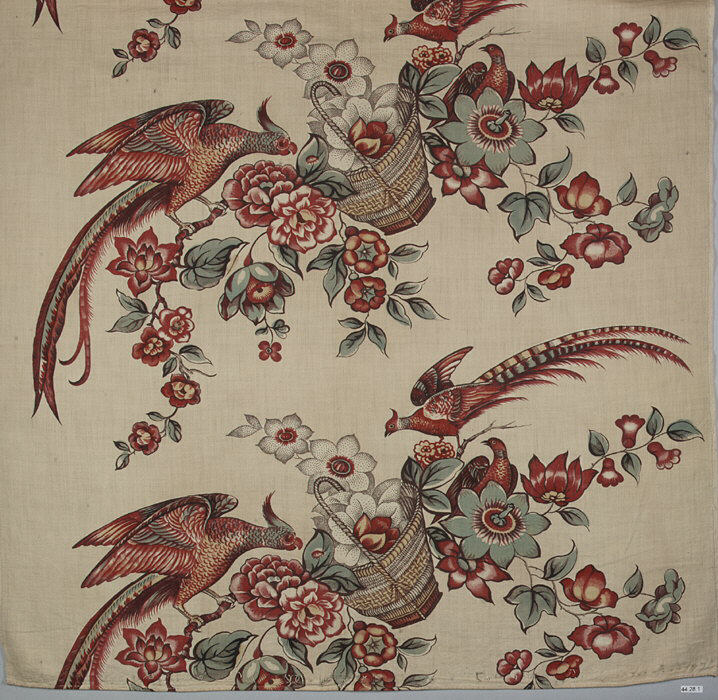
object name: piece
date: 1801-1900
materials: cotton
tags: birds,flowers